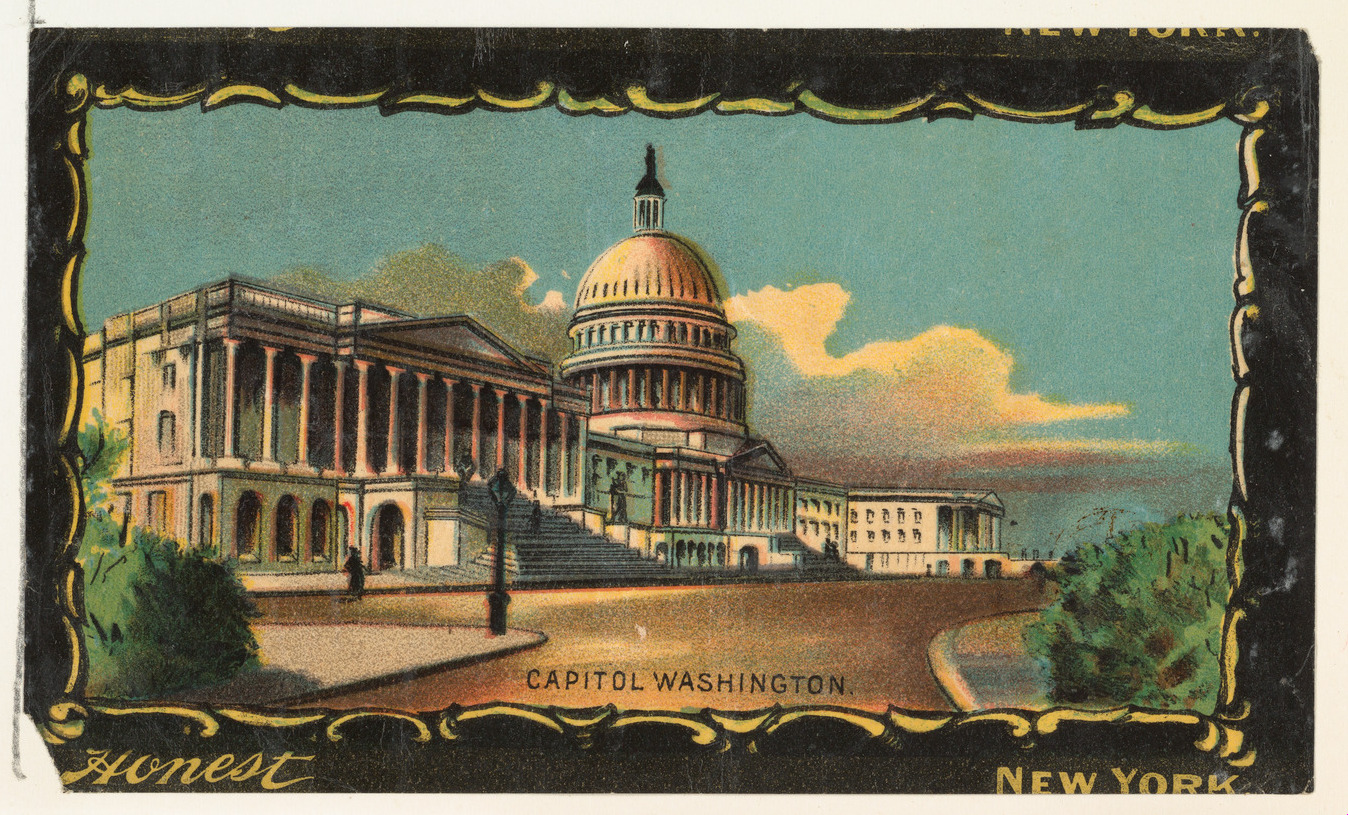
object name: print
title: Capitol, Washington, D.C., from the Transparencies series (N137) issued by W. Duke, Sons & Co. to promote Honest Long Cut Tobacco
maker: w. duke, sons & co.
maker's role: publisher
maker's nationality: american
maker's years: 1870-1920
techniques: color lithograph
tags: buildings